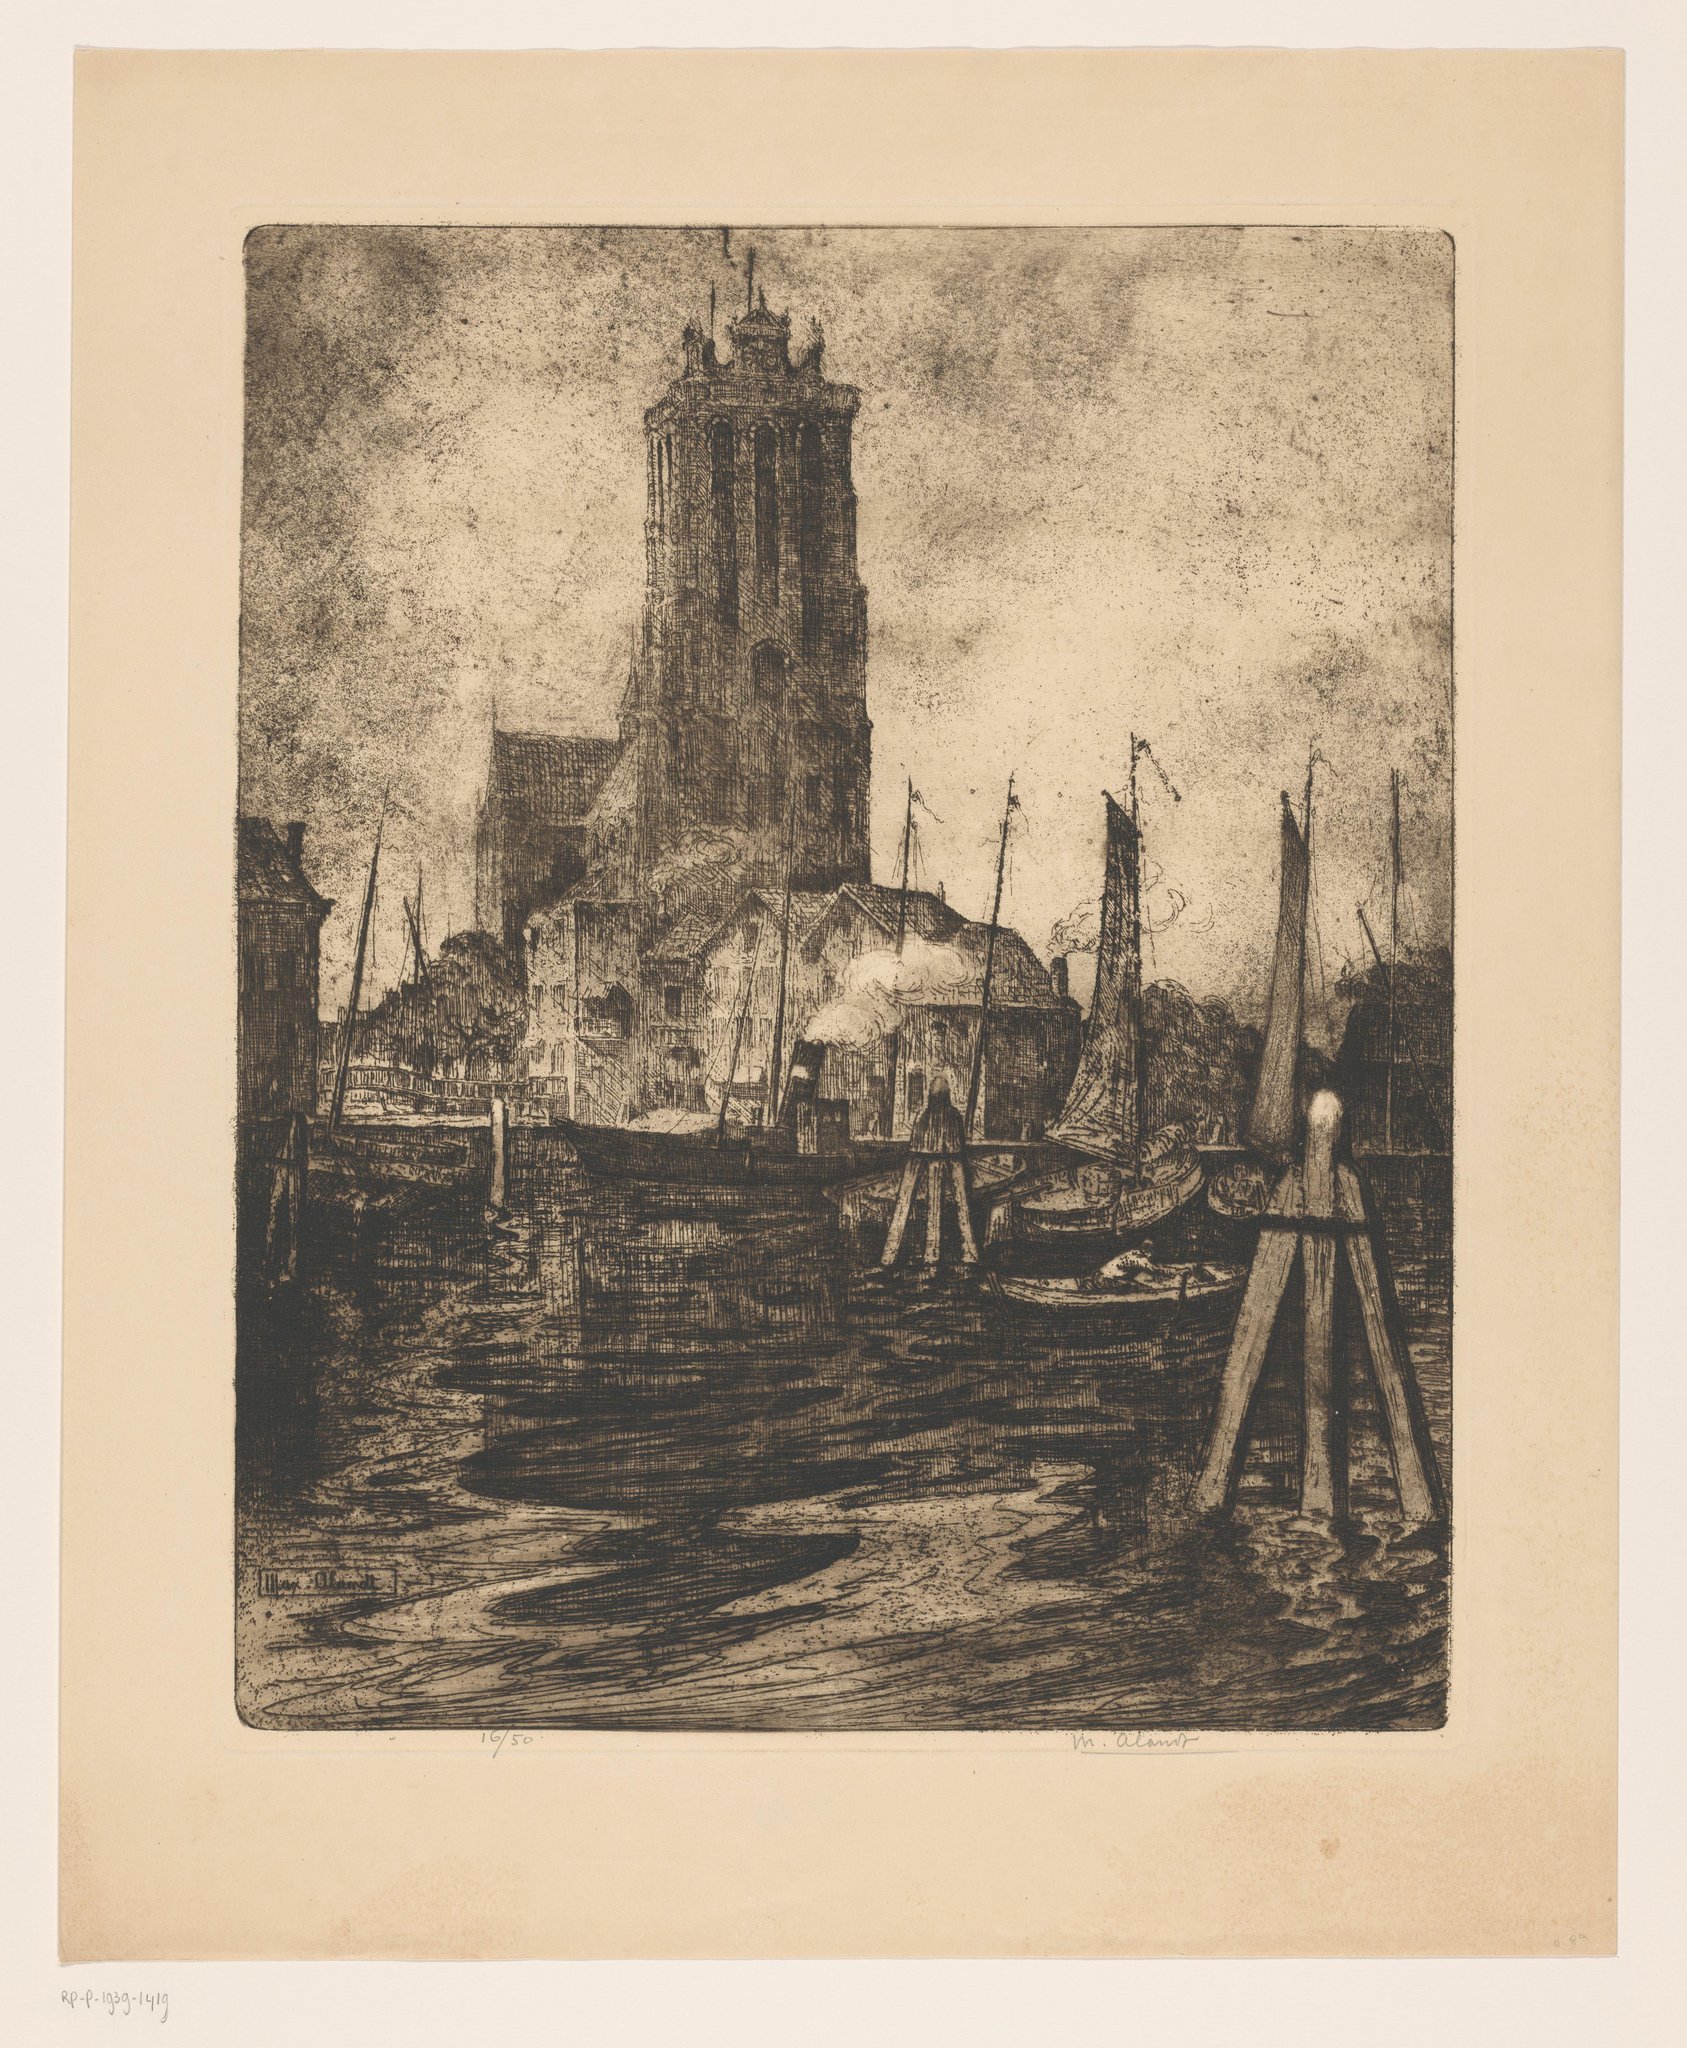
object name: print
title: Gezicht op de haven van Dordrecht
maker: max alexander alandt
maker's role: print maker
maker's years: 1875-1930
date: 1885-1930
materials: paper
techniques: etching, intaglio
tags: harbour, city-view, and landscape with man-made constructions, parts of church exterior and annexes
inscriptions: collector's mark: Lugt 2166, collector's mark: Lugt 2760